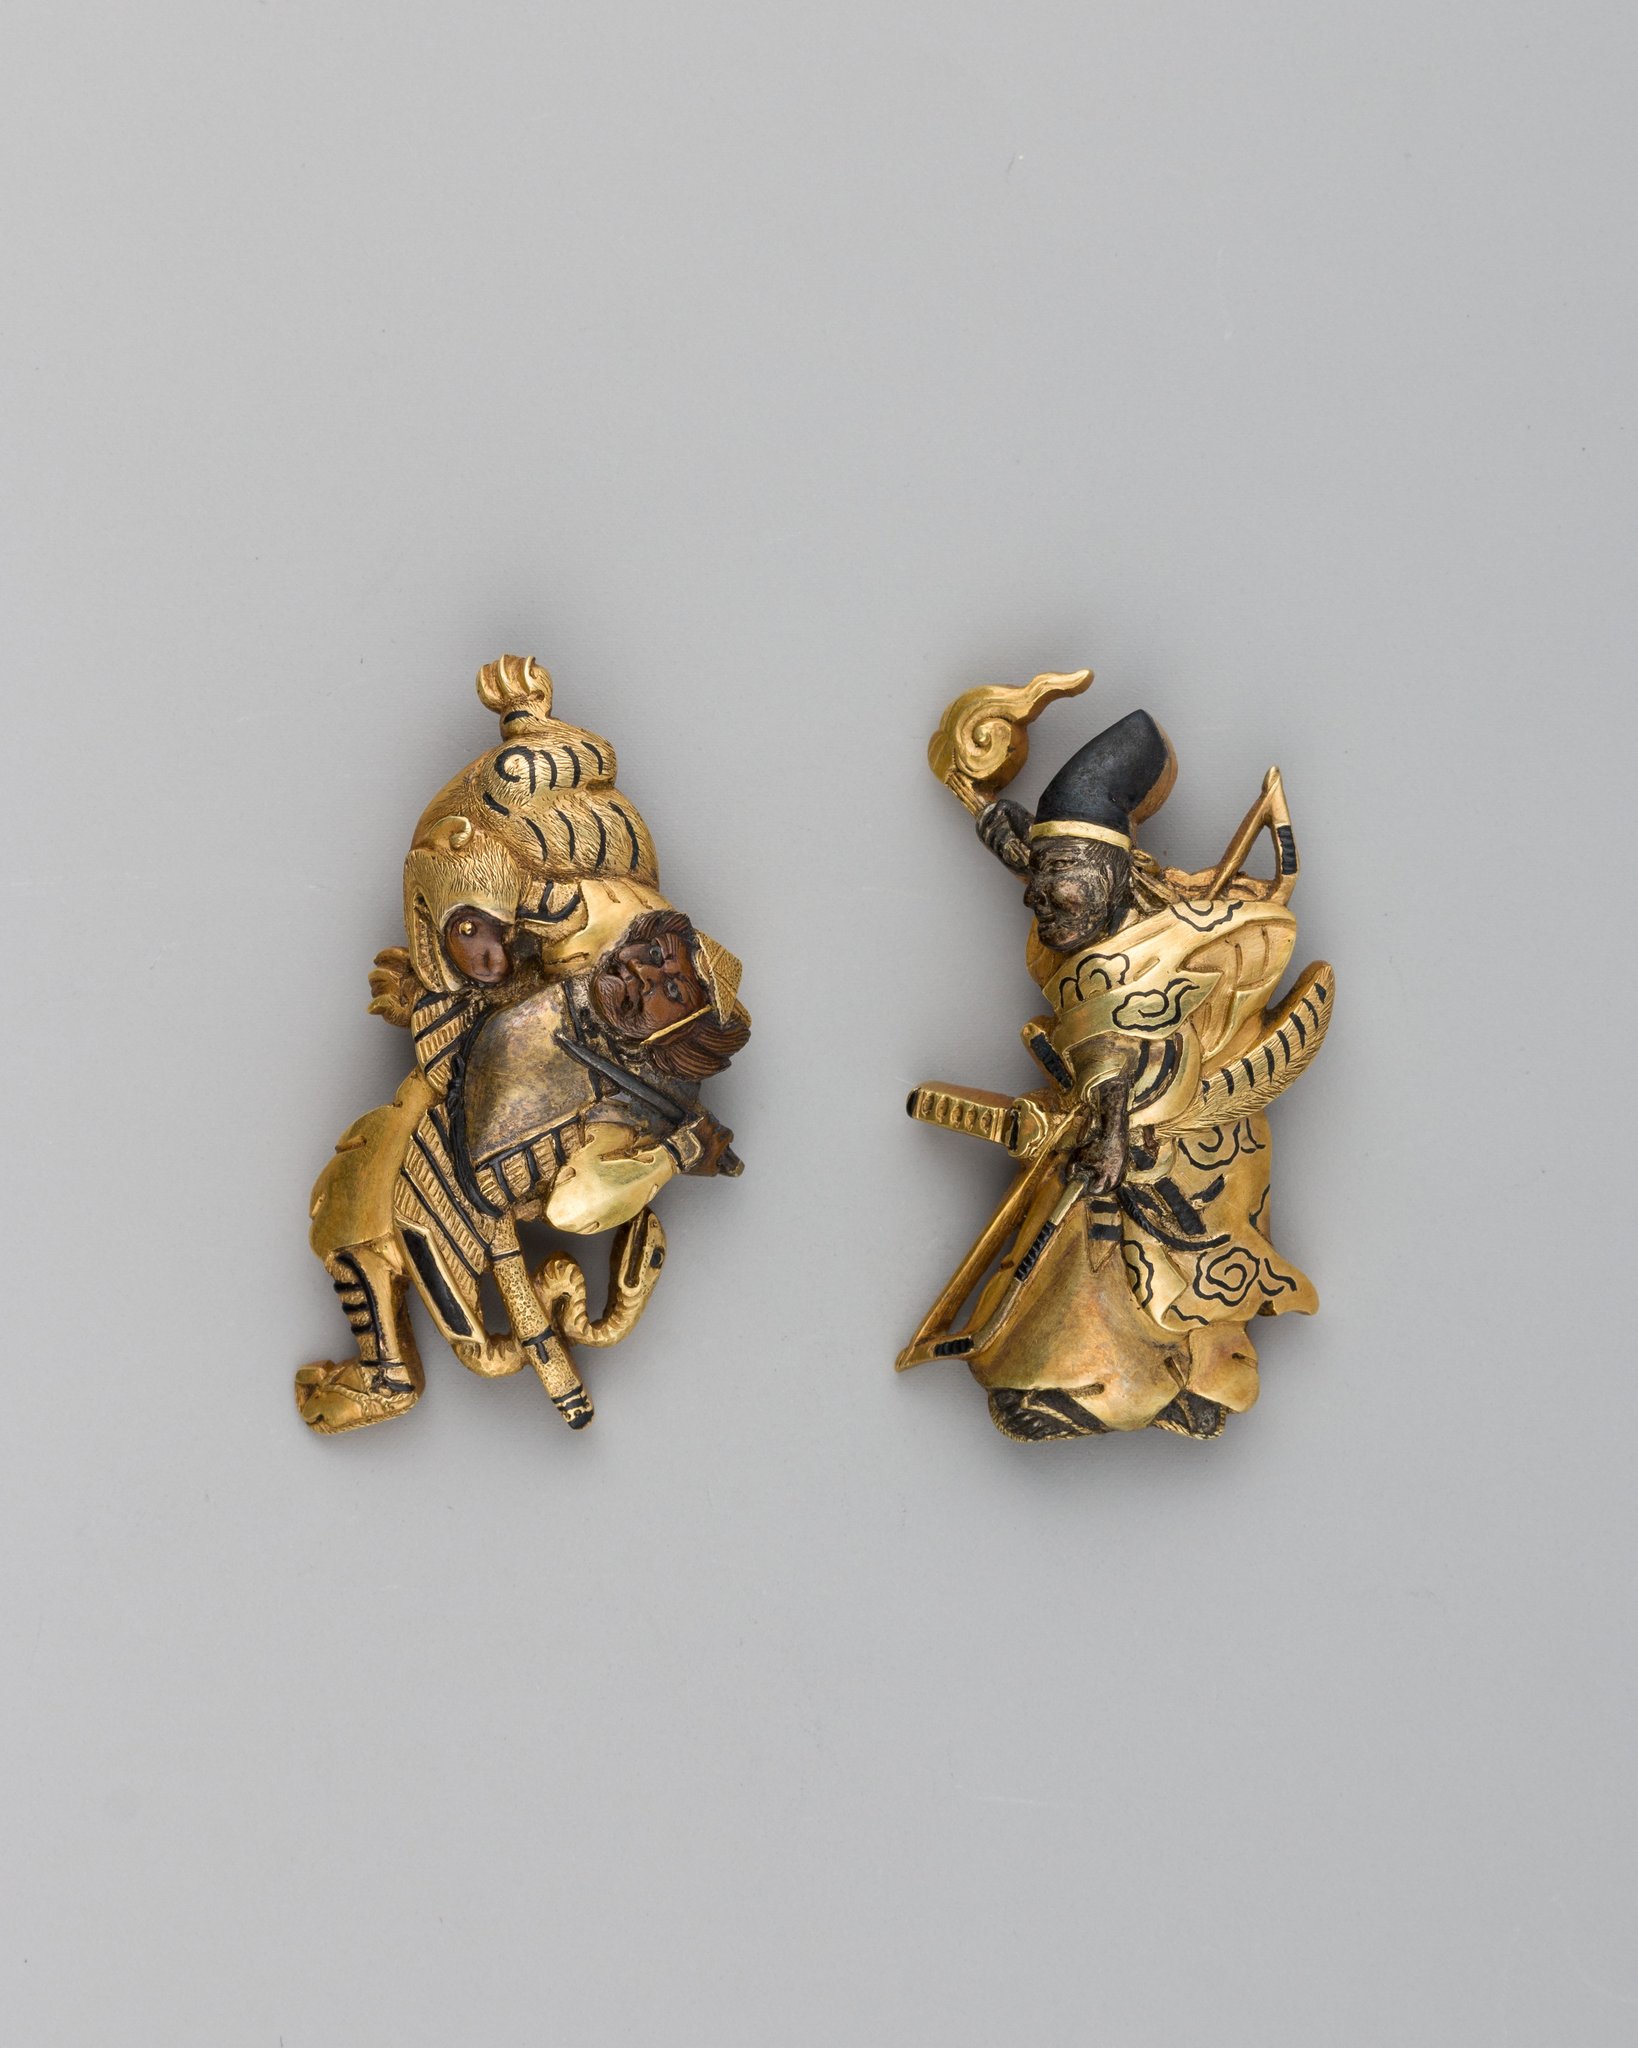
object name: pair of sword grip ornament menuki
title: Pair of Sword-Grip Ornaments (Menuki)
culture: japanese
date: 1701-1800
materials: gold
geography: japan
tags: human figures